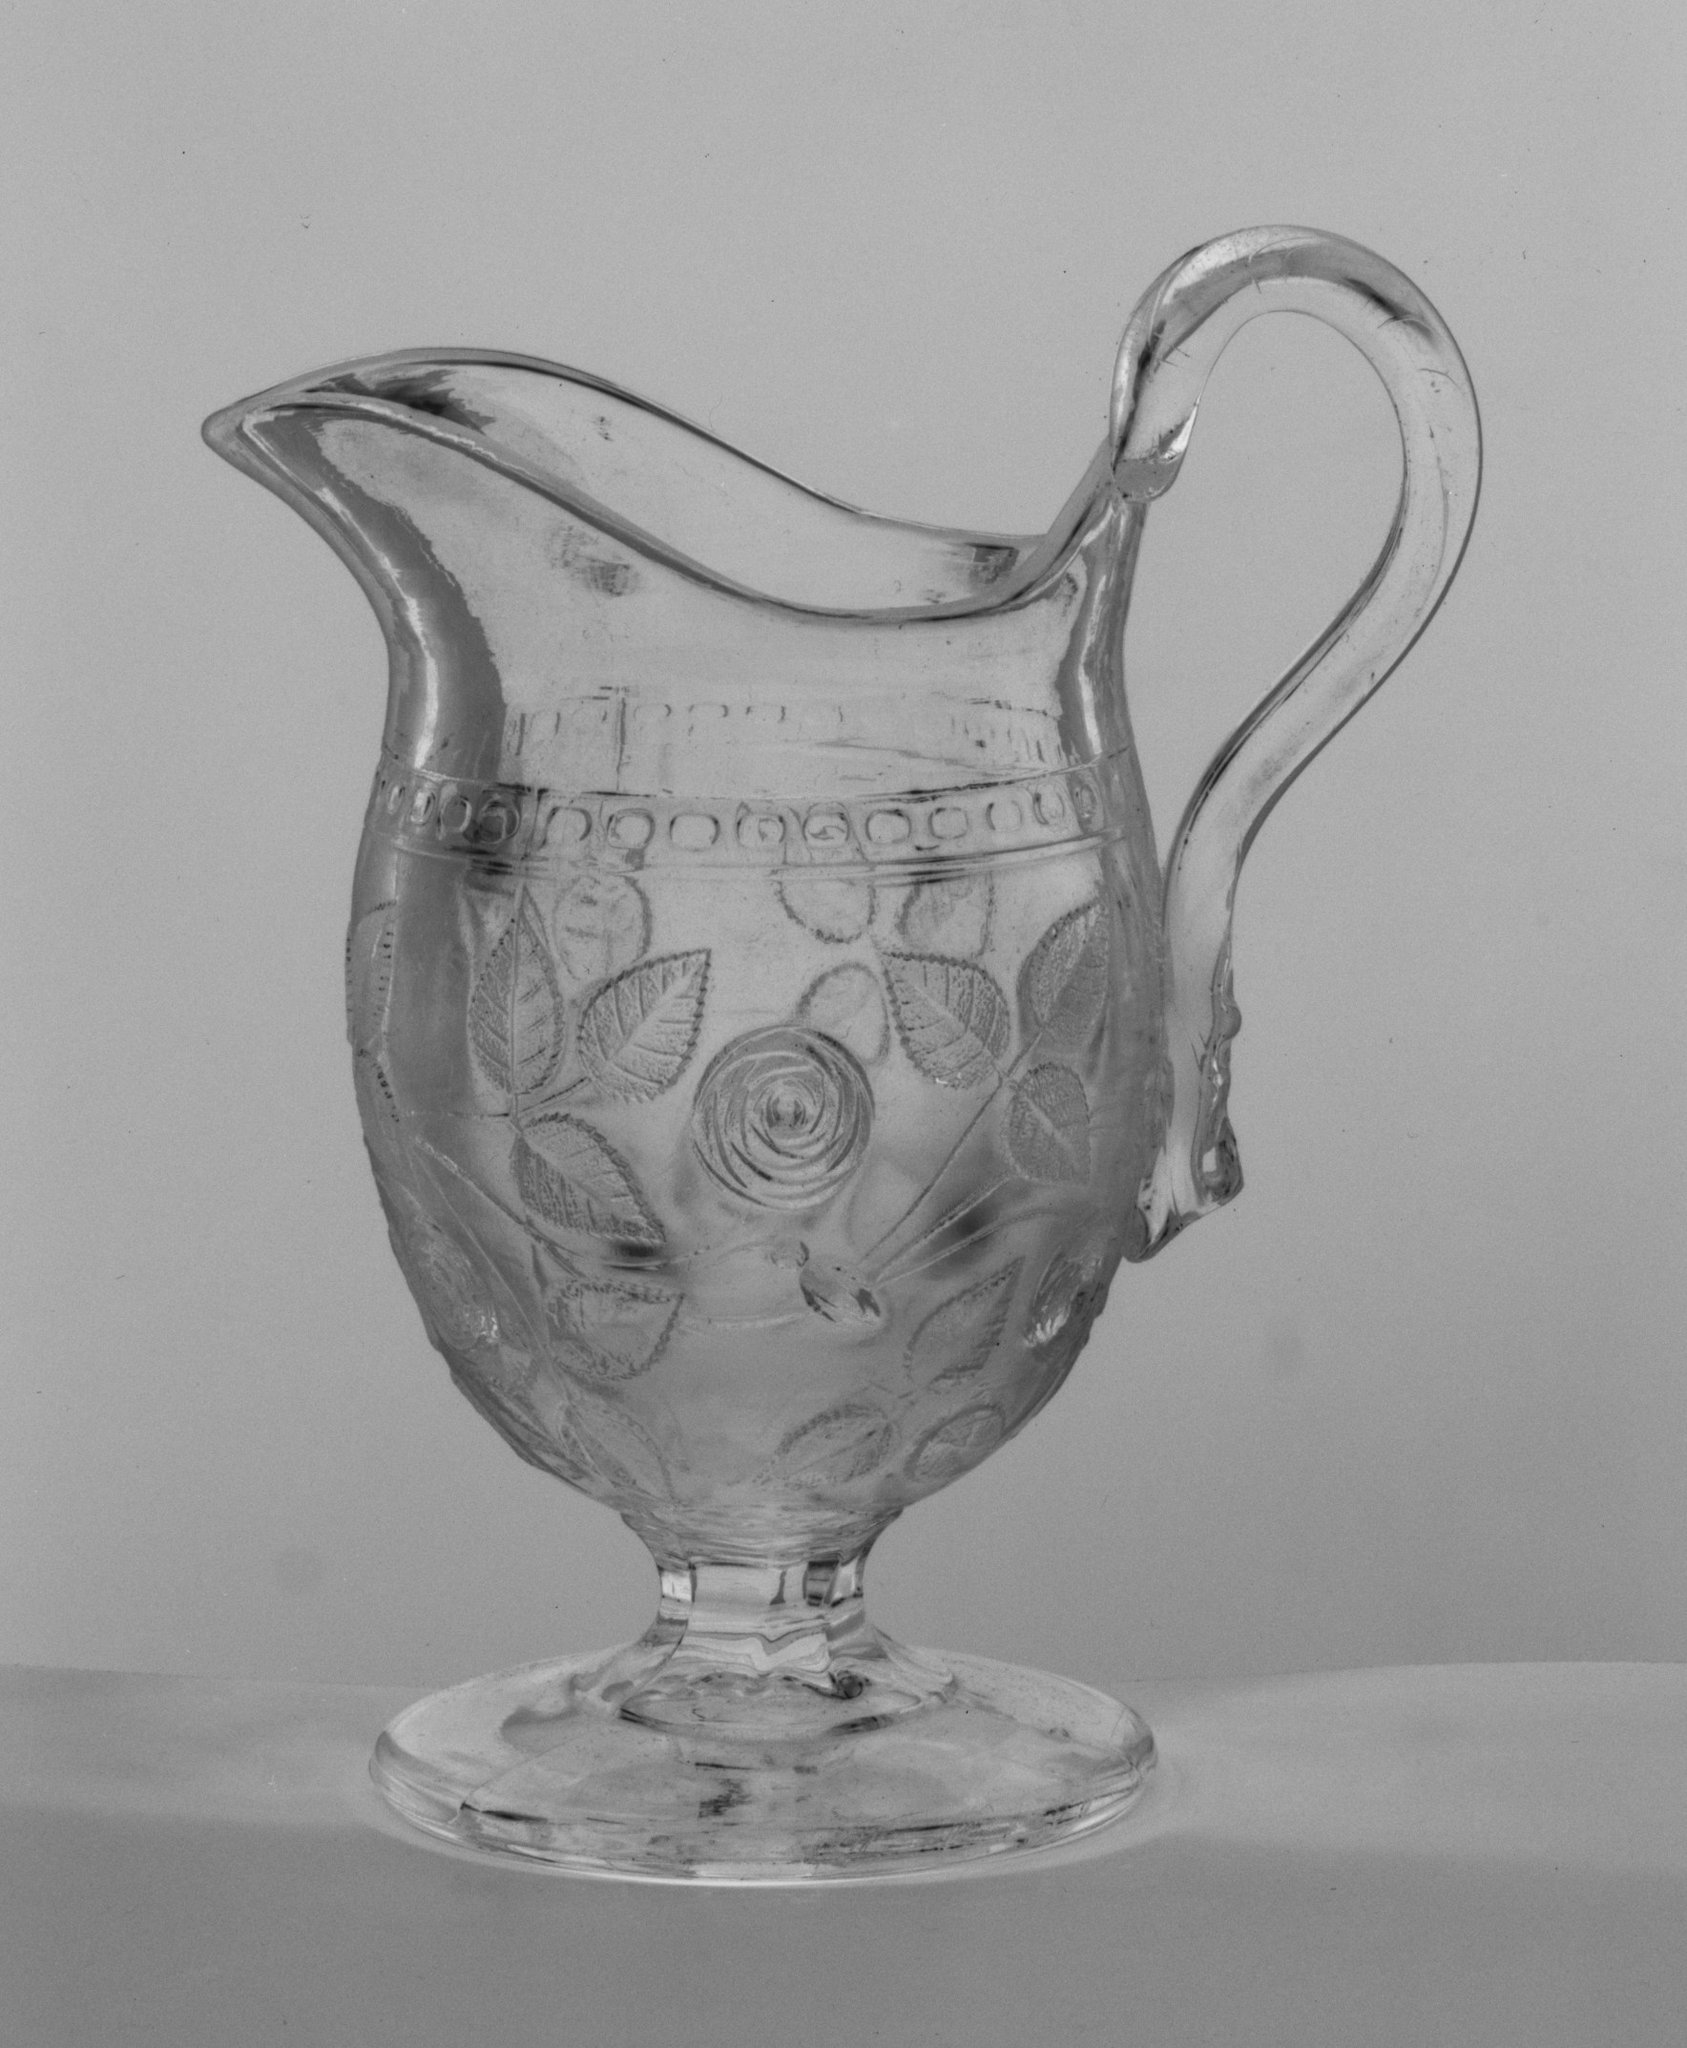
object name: cream pot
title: Creamer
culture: american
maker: central glass company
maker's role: maker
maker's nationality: american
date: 1865-1870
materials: glass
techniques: pressed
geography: united states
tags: roses